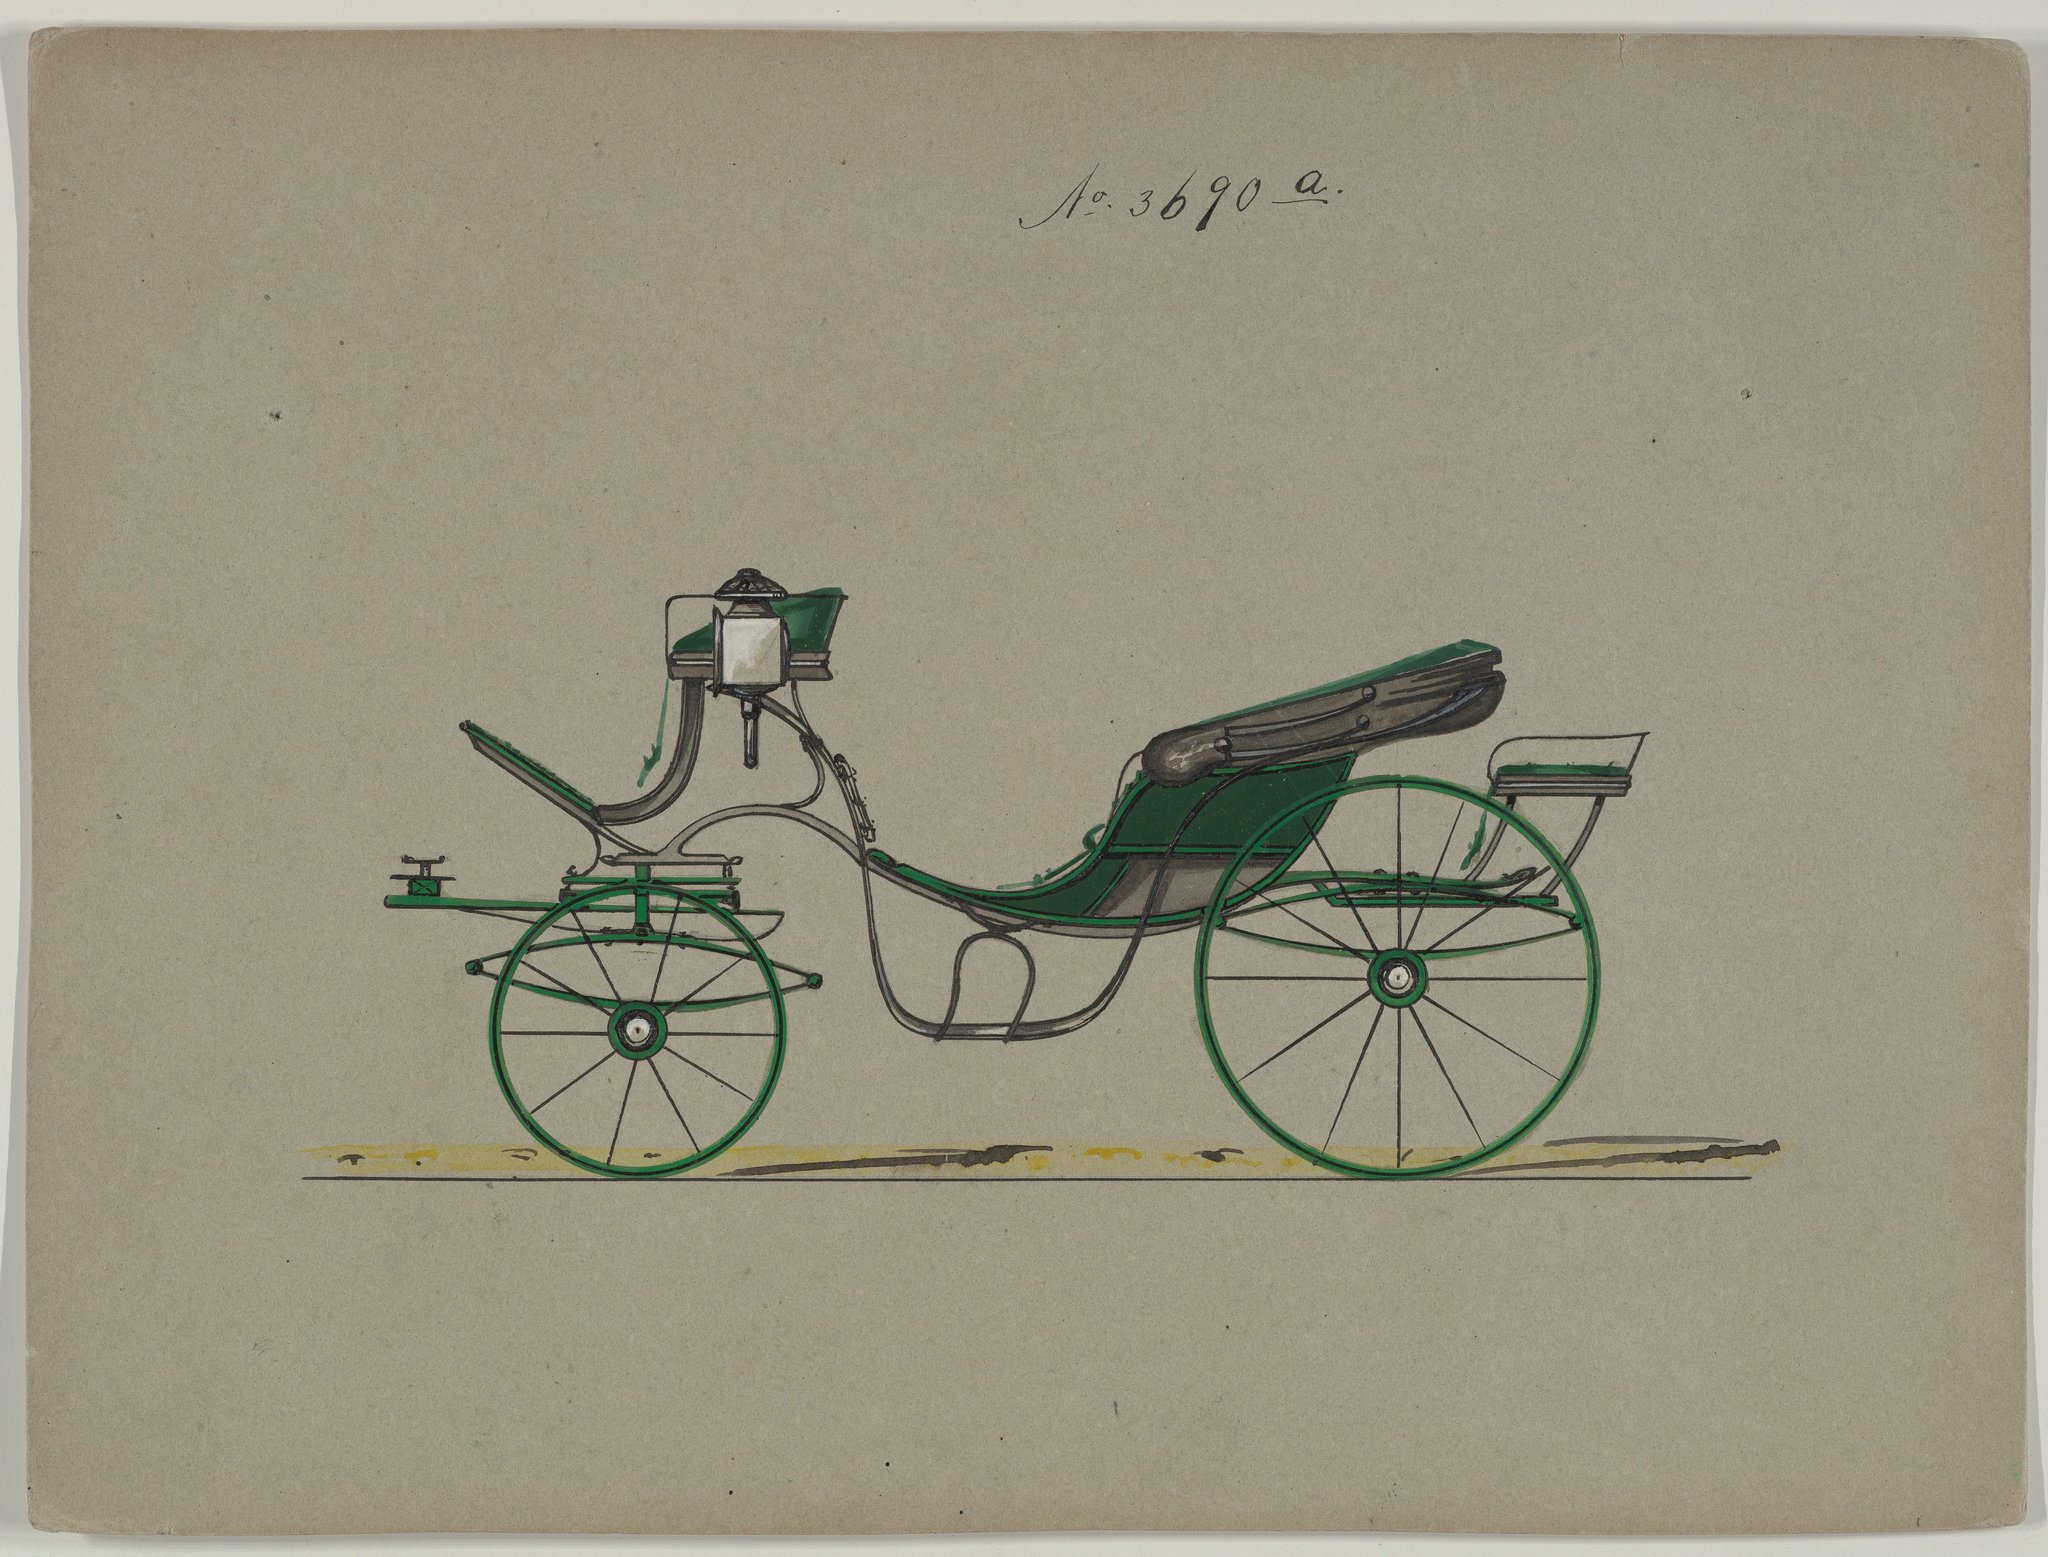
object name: drawing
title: Design for Cabriolet or Victoria, no. 3690a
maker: brewster & co.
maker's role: manufacturer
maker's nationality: american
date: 1881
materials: gouache, gum arabic, ink, watercolor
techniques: pen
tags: carriages